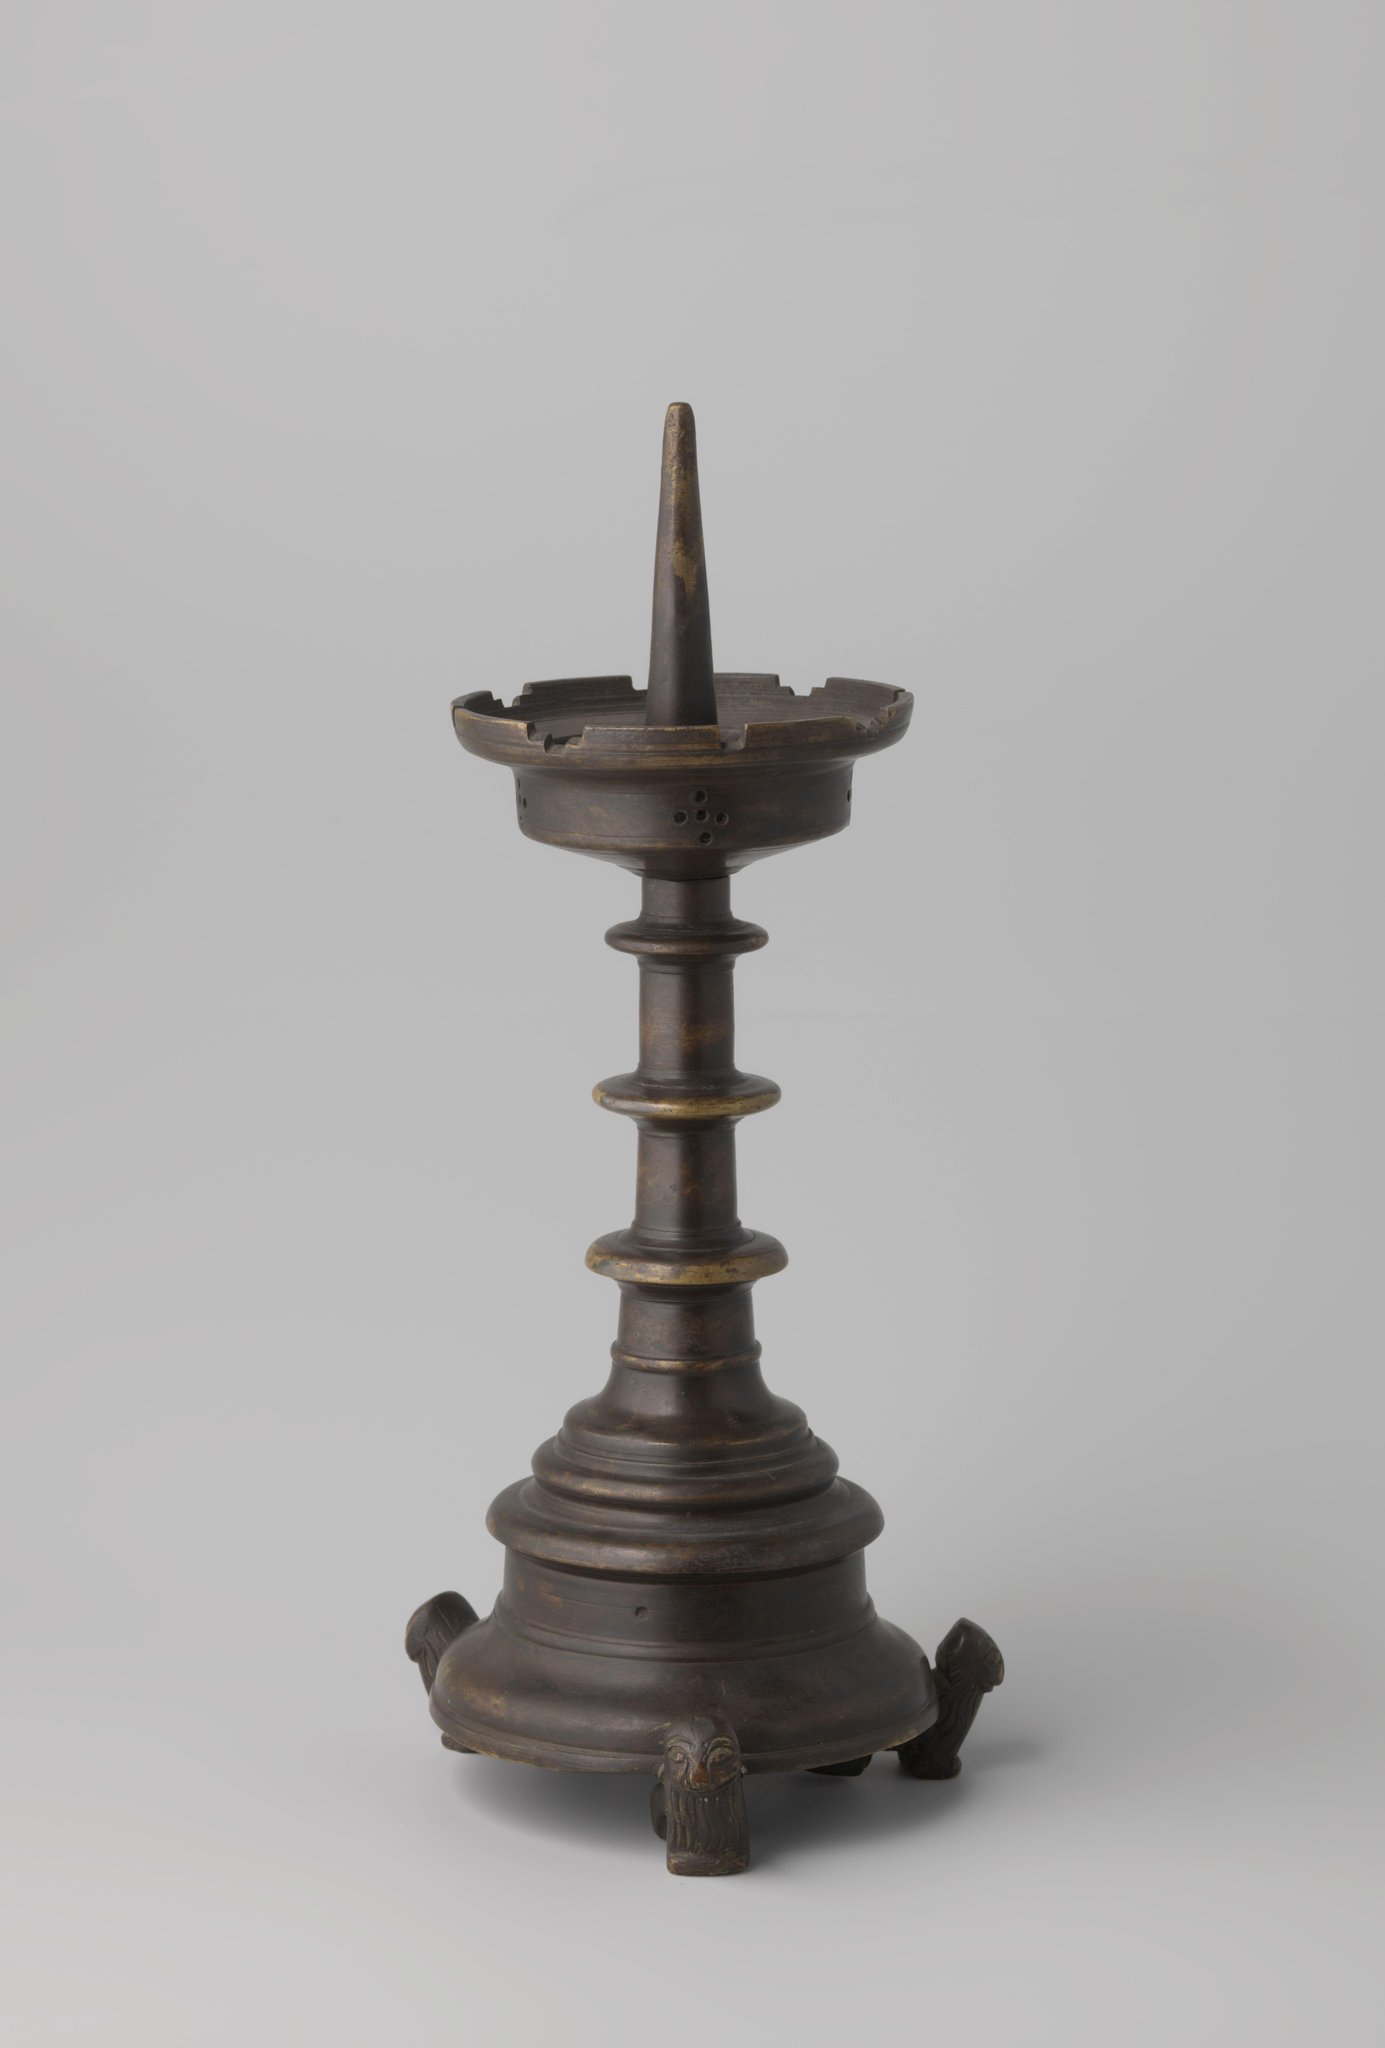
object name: forgery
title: Kandelaar met geprofileerde voet en stam, rustend op drie leeuwen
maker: Anonymous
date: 1850-1900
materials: brass, iron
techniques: brazing, casting, punching, riveted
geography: western europe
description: De kandelaar is samengesteld uit de volgende delen: de voet en de stam, die in één geheel zijn gegoten, de vetvanger, de kaarsenpin en de drie voetstukken. De voet is van binnen hol tot de onderste knoop. De geprofileerde konische voet gaat over in de ronde stam met drie knopen. Hierop bevindt zich bij de vetvanger met bovenop de forse ongeprofileerde kaarsenpin. De ronde verdiepte vetvanger heeft een platte liggende rand, die overgaat in een smalle opstaande rand met acht ongelijke kantelen. In de opstaande rand van de vetvanger zijn vier versieringen aangebracht, bestaande uit een perforatie in de vorm van een vijfpas. Voet, stam en vetvanger zijn versierd met gegroefde ringen. De kandelaar heeft onder aan de binnenkant drie nokken, waarin ijzeren bouten zijn bevestigd, waarin de leeuwtjes zijn vastgeklonken, die als voetstukken dienen.